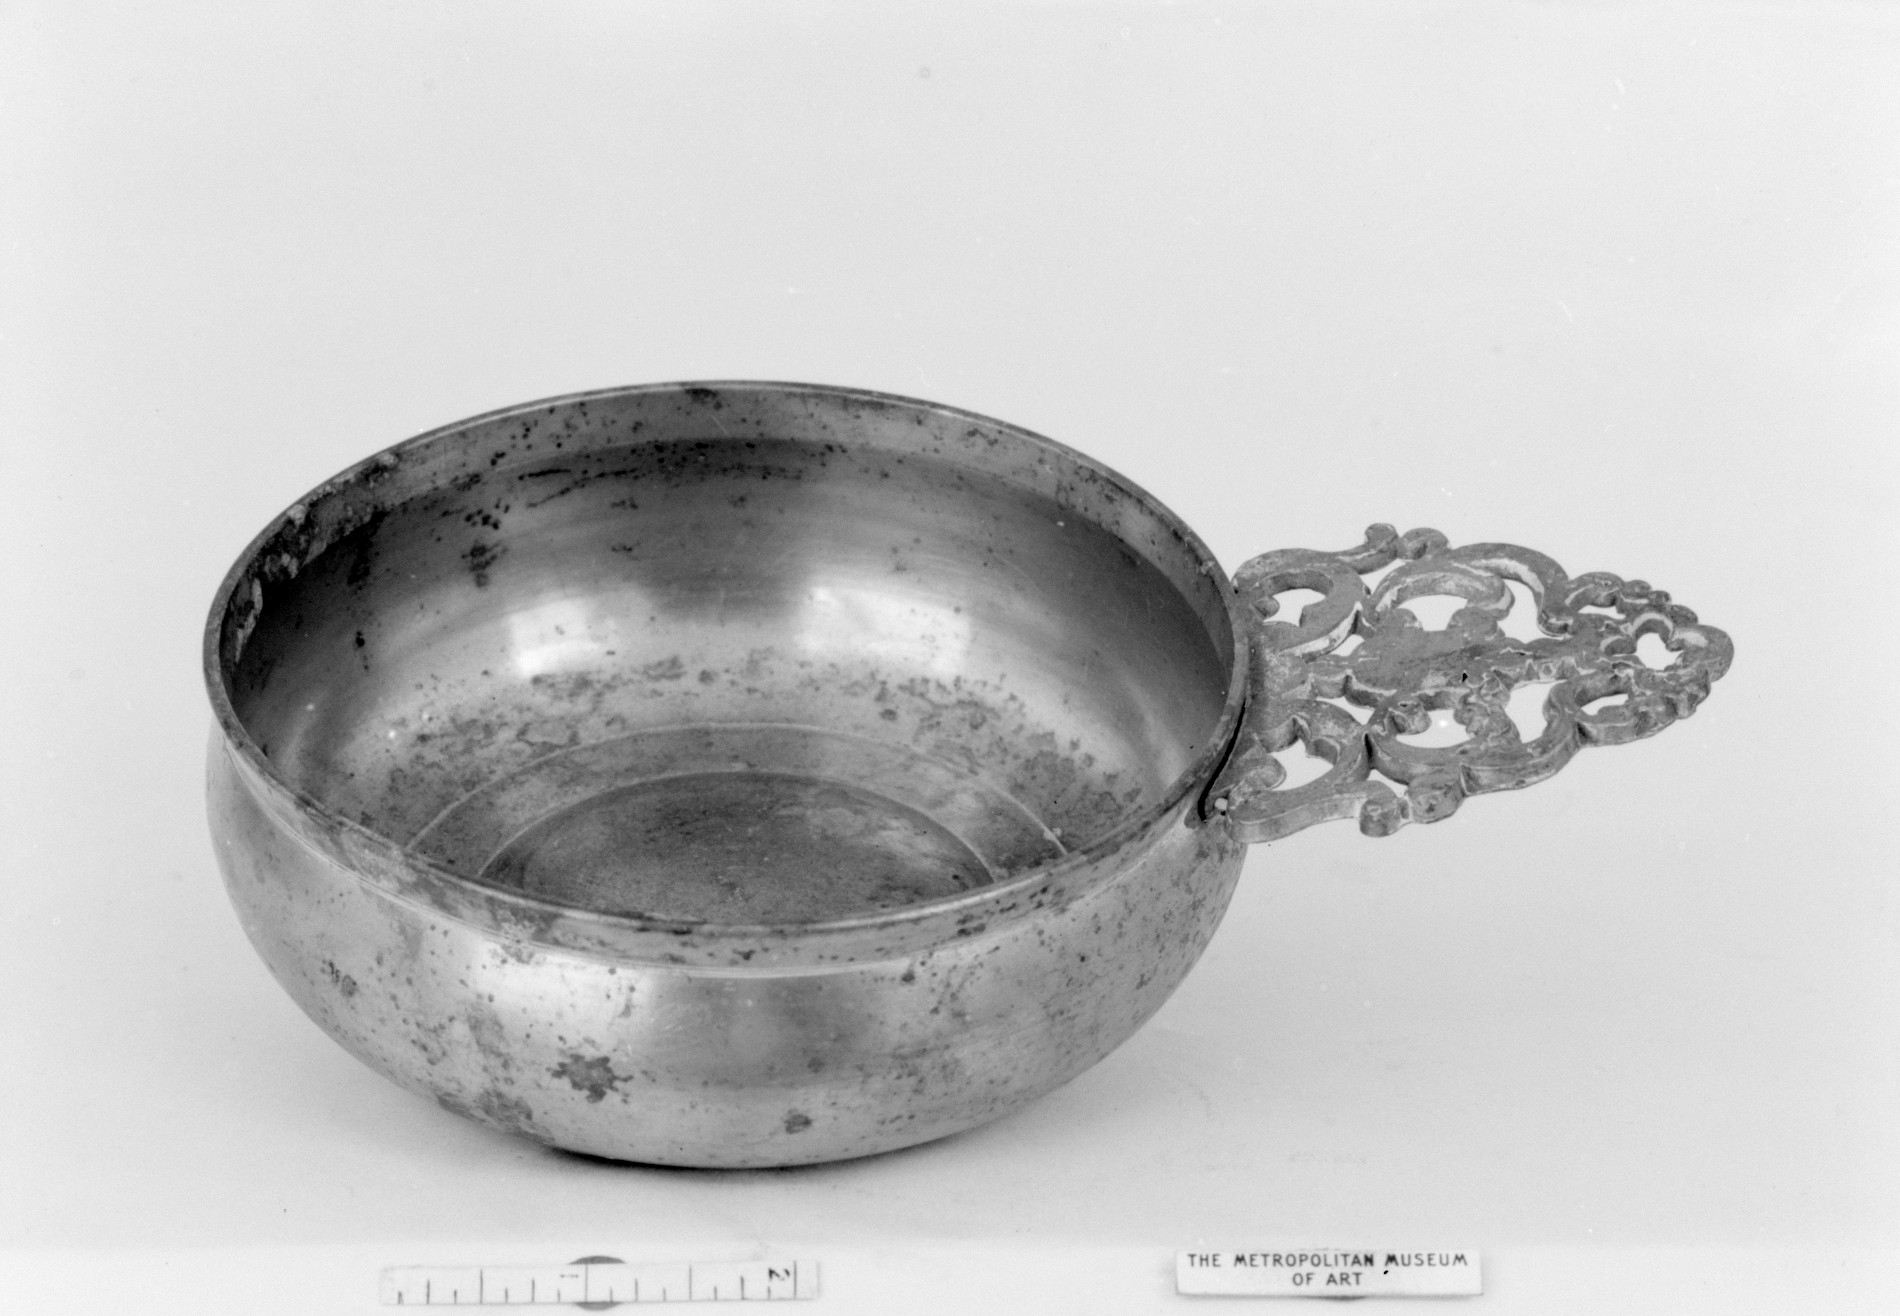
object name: porringer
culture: american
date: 1700-1800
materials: pewter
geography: united states